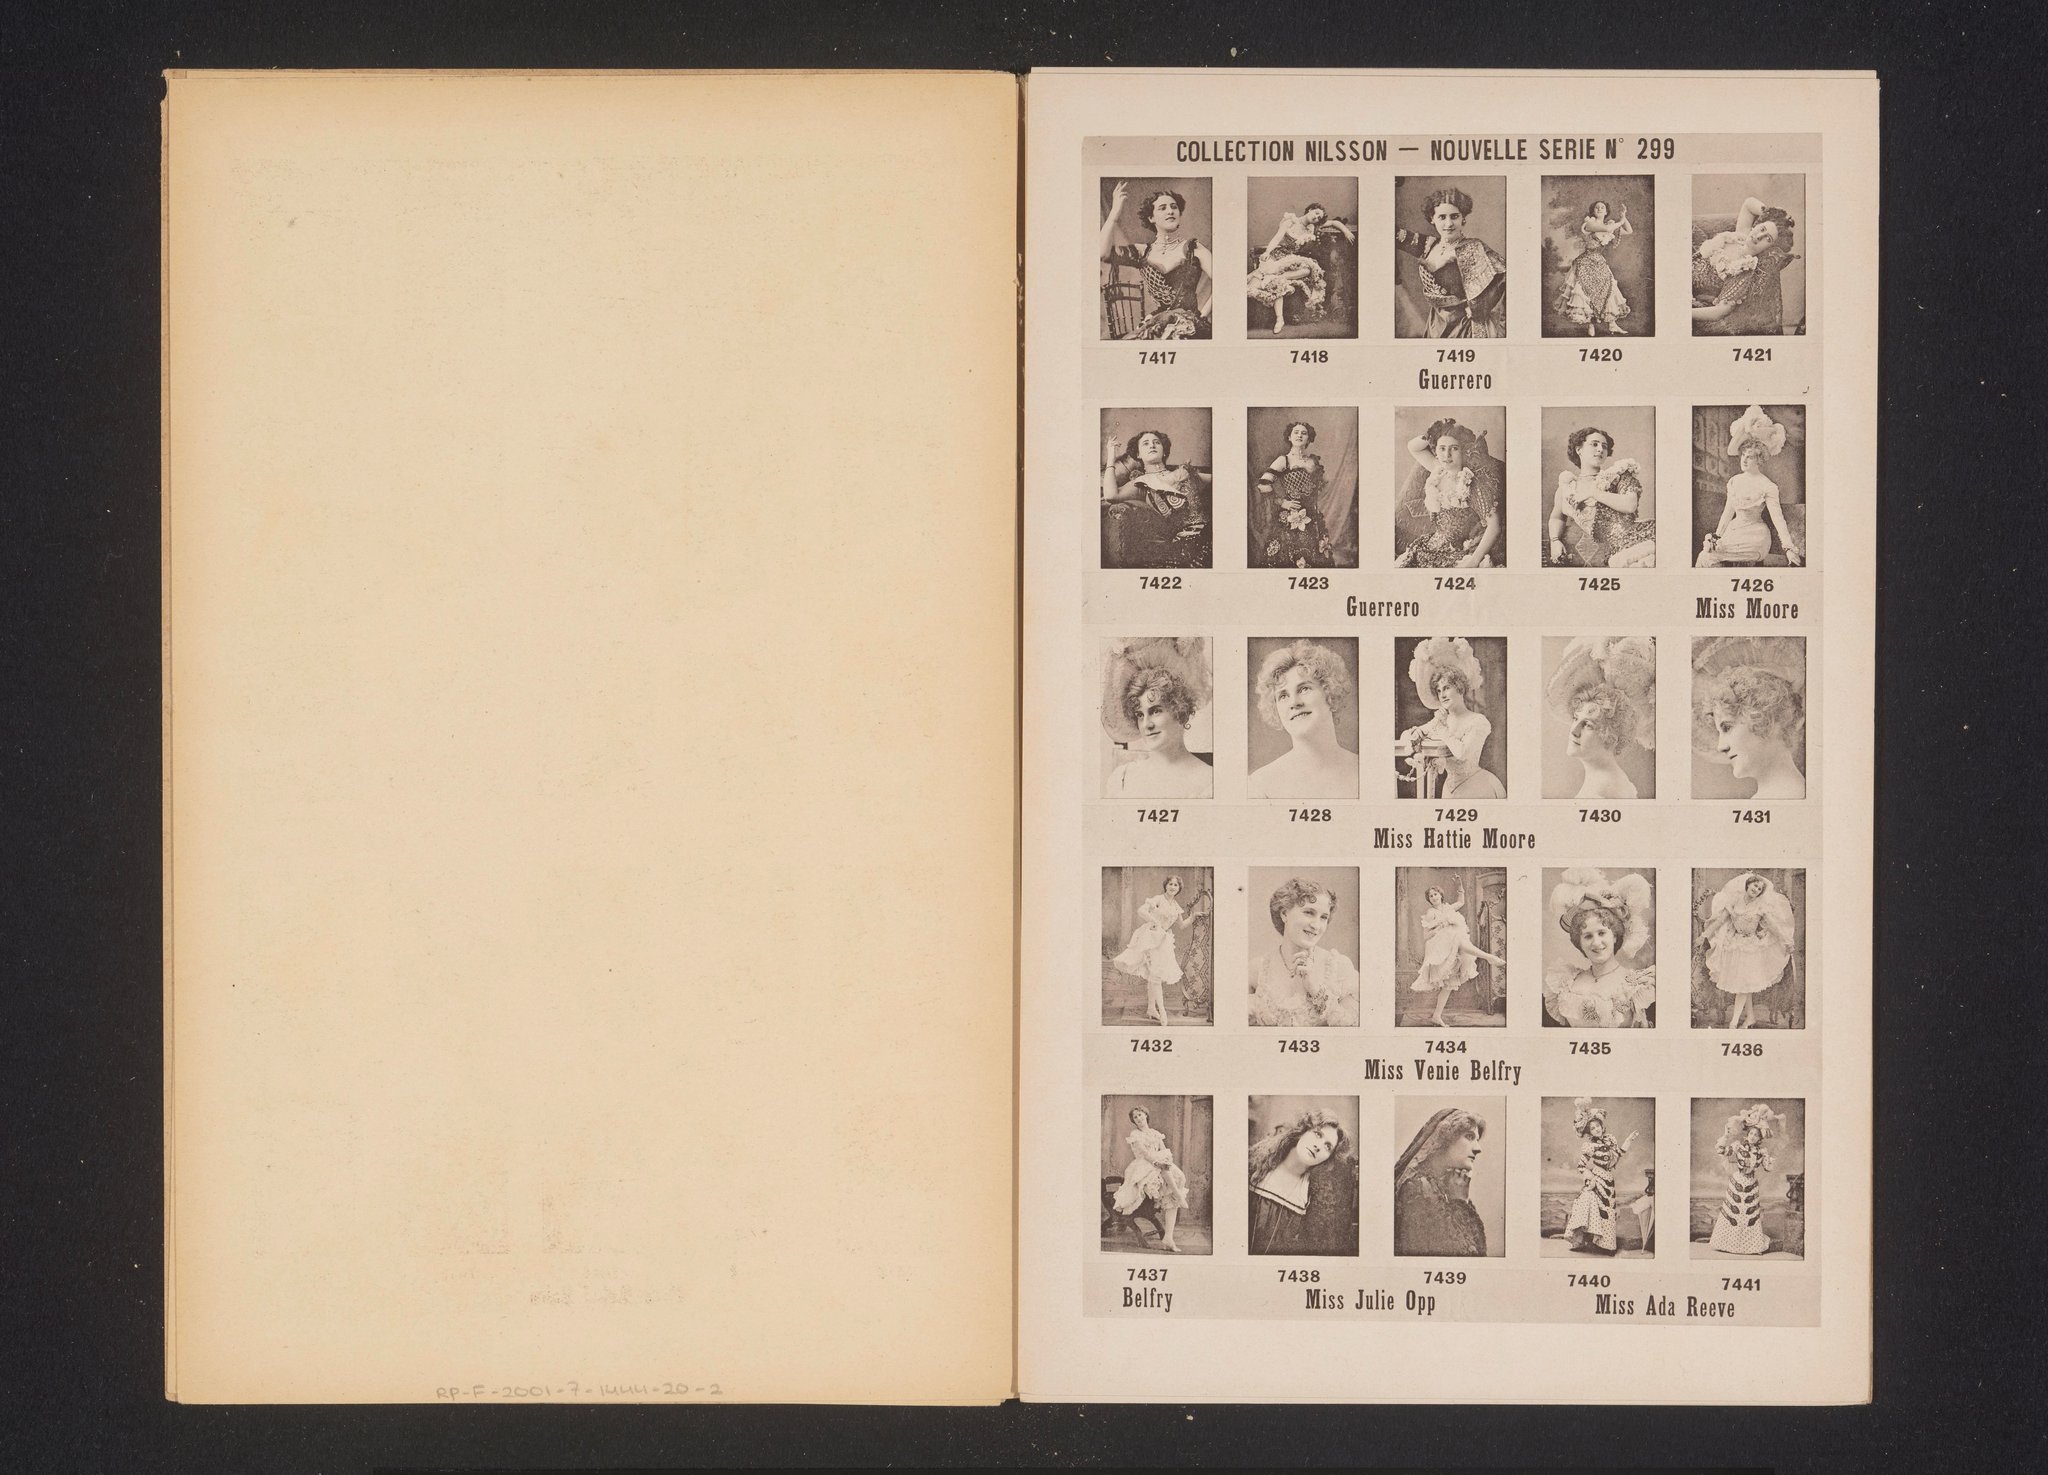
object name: page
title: Collection Nilsson - Nouvelle Série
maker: Anonymous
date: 1895-1900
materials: paper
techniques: photograph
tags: new york (city), historical persons - bb - woman, portrait of actor, actress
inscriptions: number: ‘No 299’